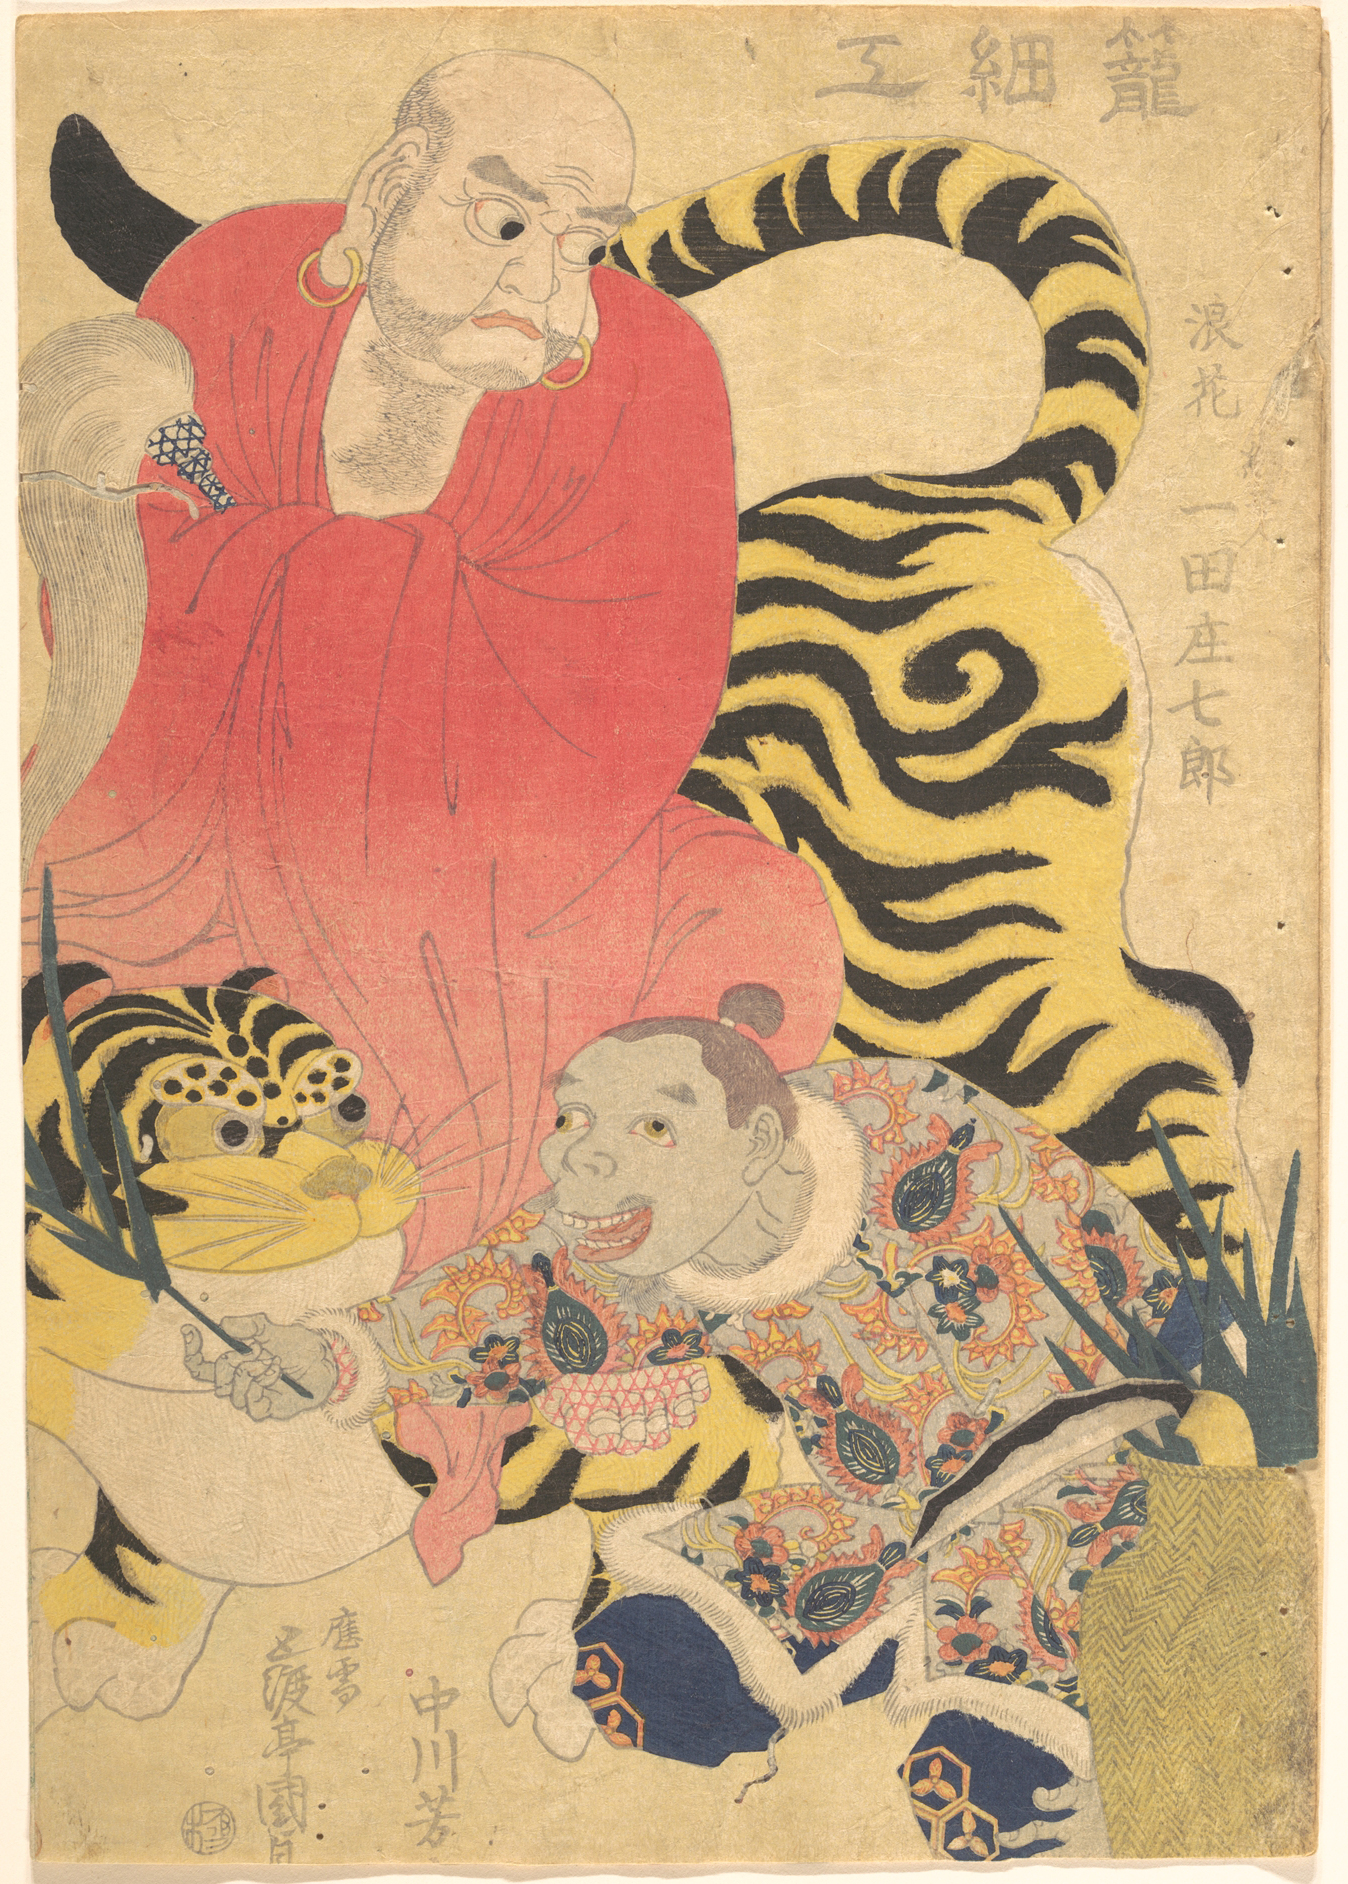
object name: print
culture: japanese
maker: utagawa kunisada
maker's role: artist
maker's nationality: japanese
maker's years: 1786-1864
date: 1801-1900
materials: ink, paper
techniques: woodblock print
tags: men,tigers